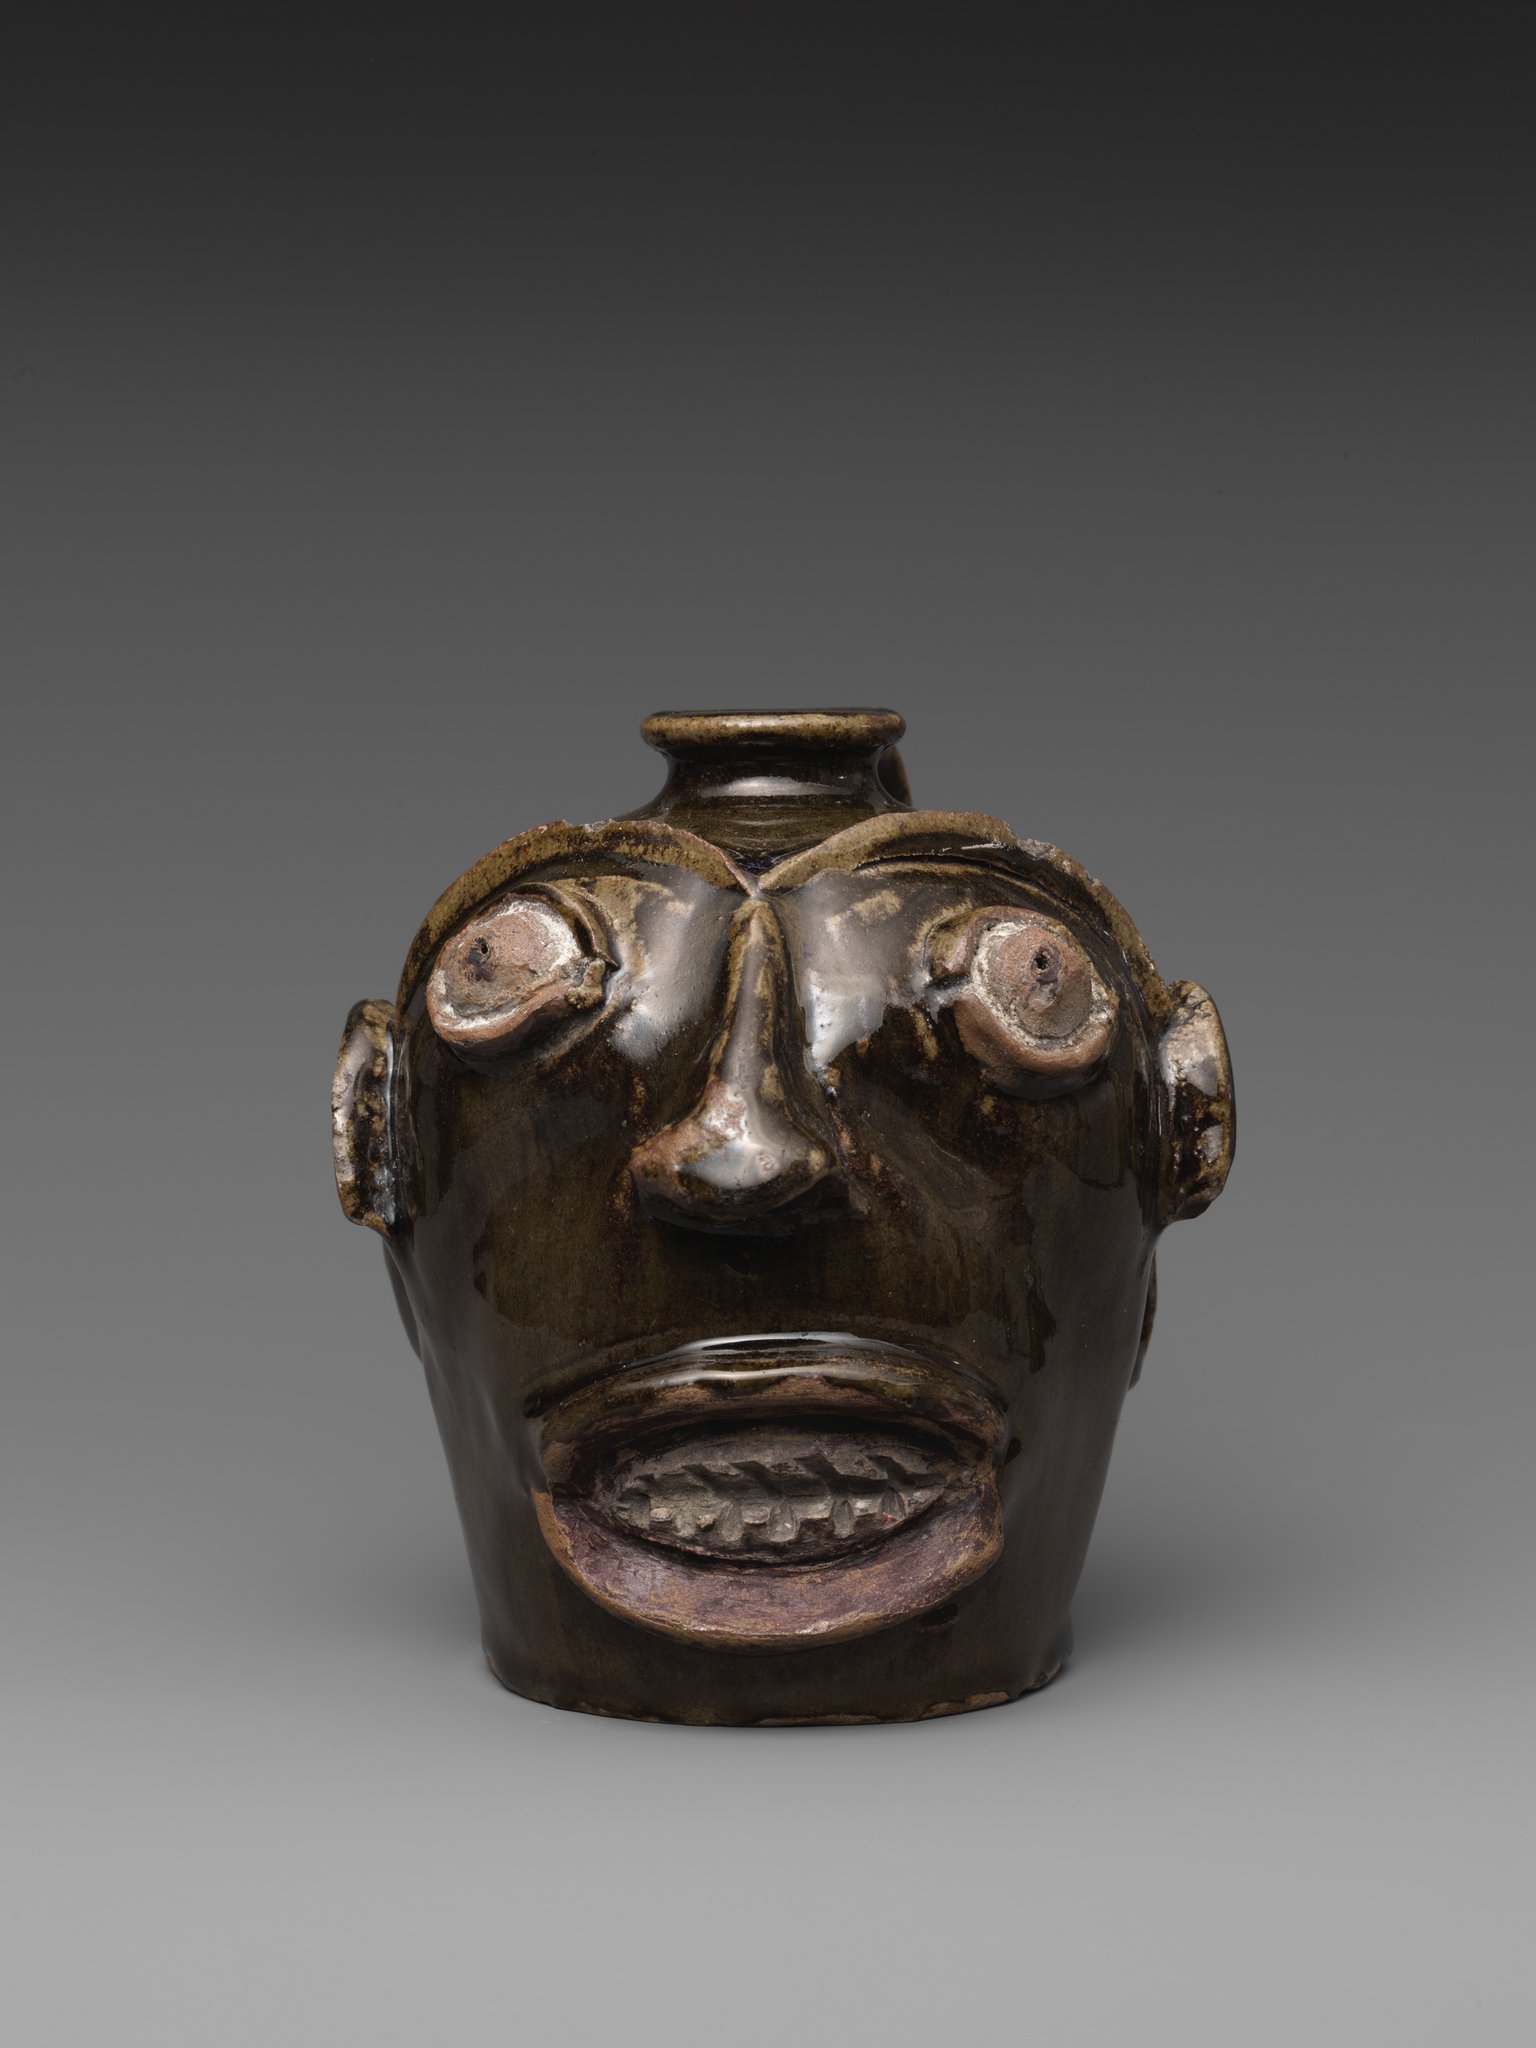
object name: face jug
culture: american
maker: unrecorded edgefield district potter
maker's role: maker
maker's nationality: american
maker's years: 1800-1920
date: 1850-1880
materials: stoneware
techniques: glazing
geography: united states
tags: faces